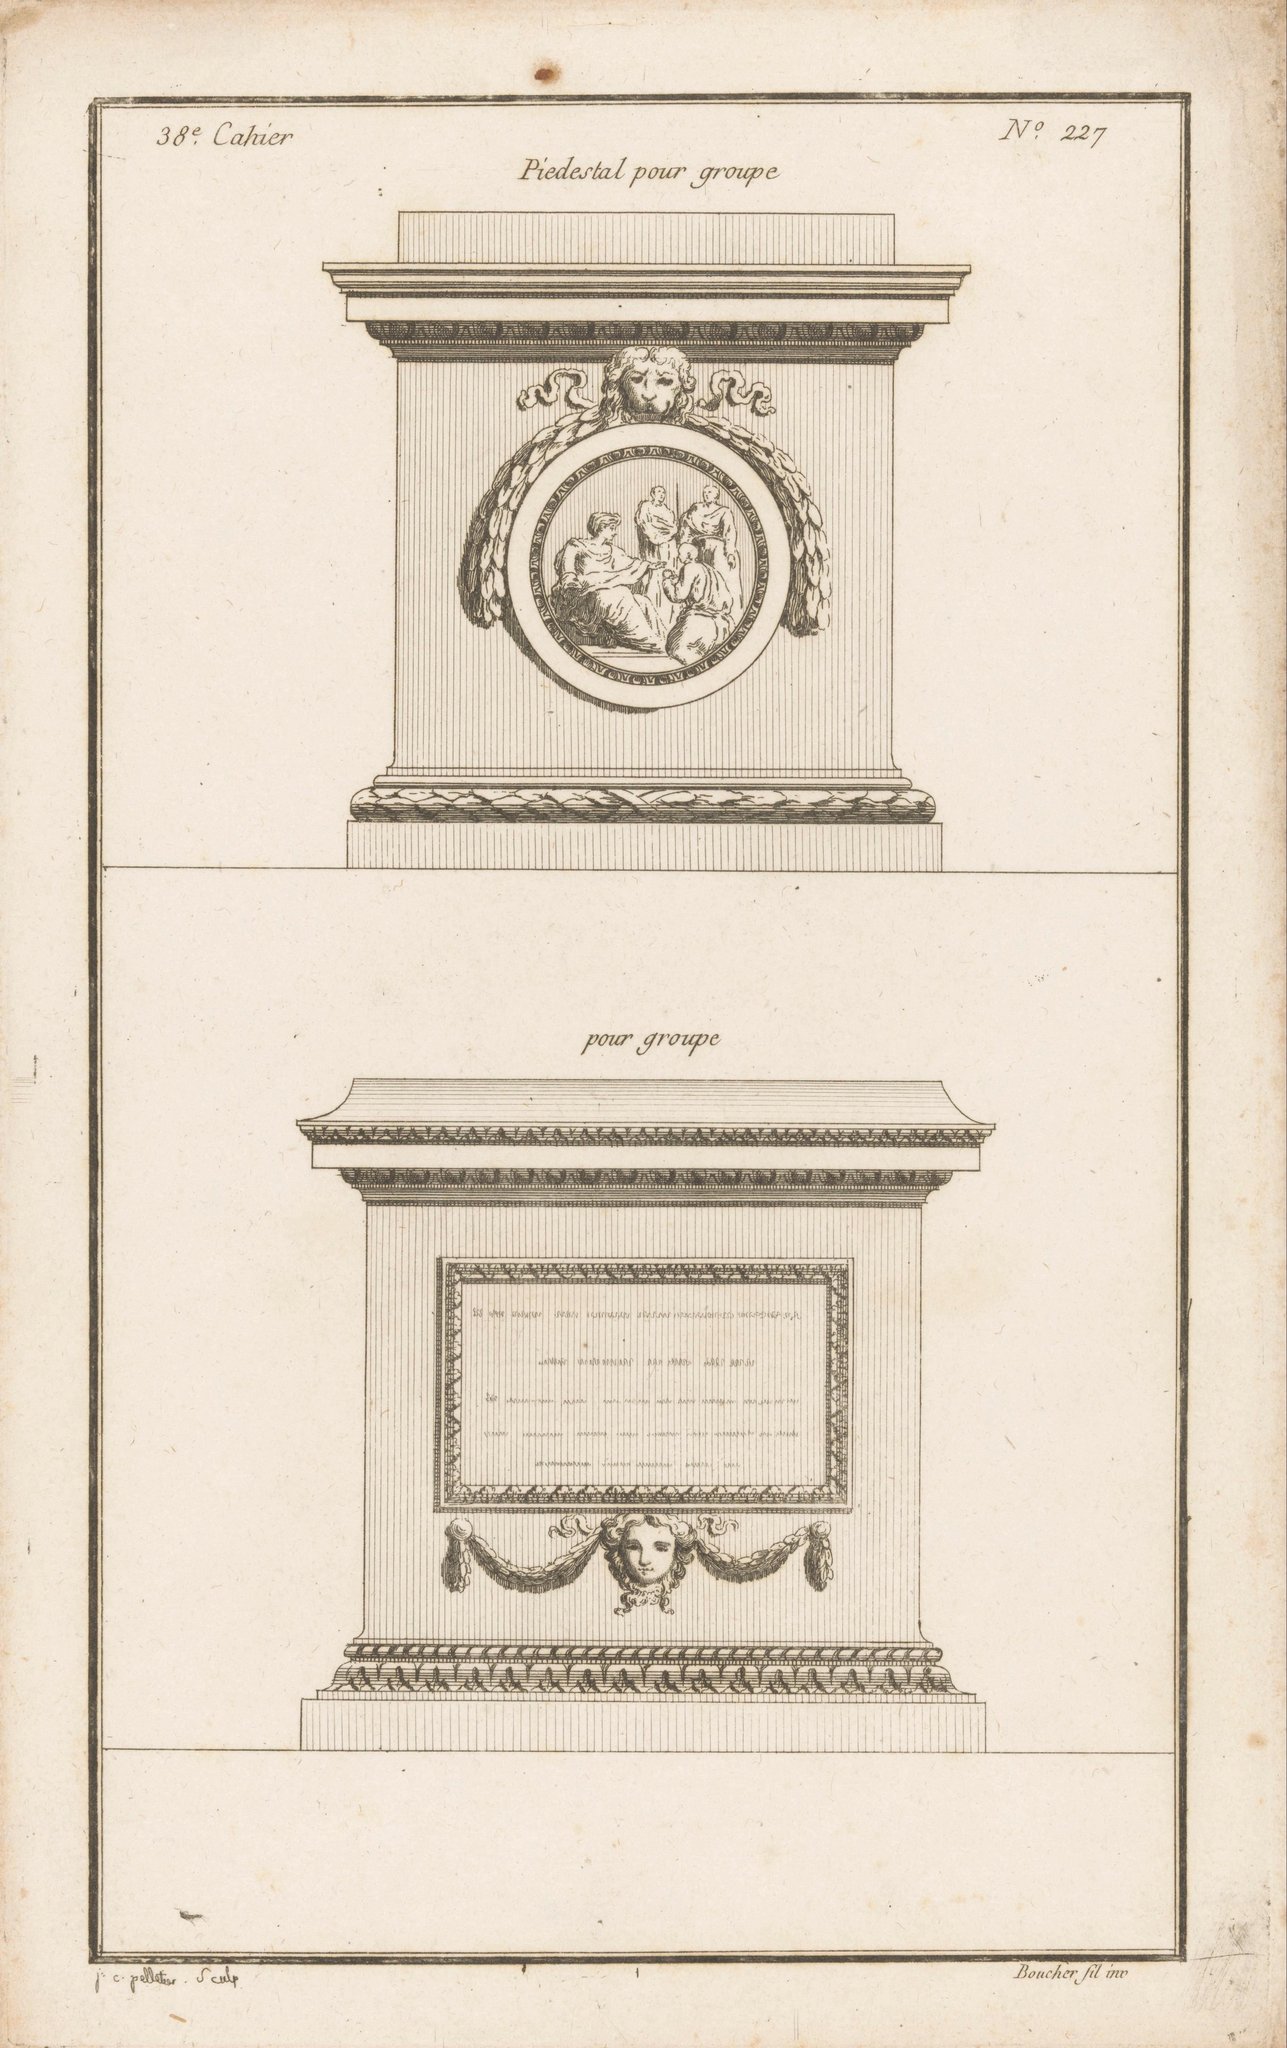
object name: ornament print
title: Twee voetstukken met medaillon en tablet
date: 1772-1779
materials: paper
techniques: engraving, etching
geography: paris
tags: lion's head ~ ornament, ornament ~ medallion, pedestal of a piece of sculpture (perhaps in the form of a herm), mask, mascaron ~ ornament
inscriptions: collector's mark: Lugt 2228, collector's mark: Lugt 2760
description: Twee voetstukken. Boven met een leeuwenkop boven een rond medaillon met figuren, onder met een masker en guirlandes onder een rechthoekig tablet. Prentnummer 227.